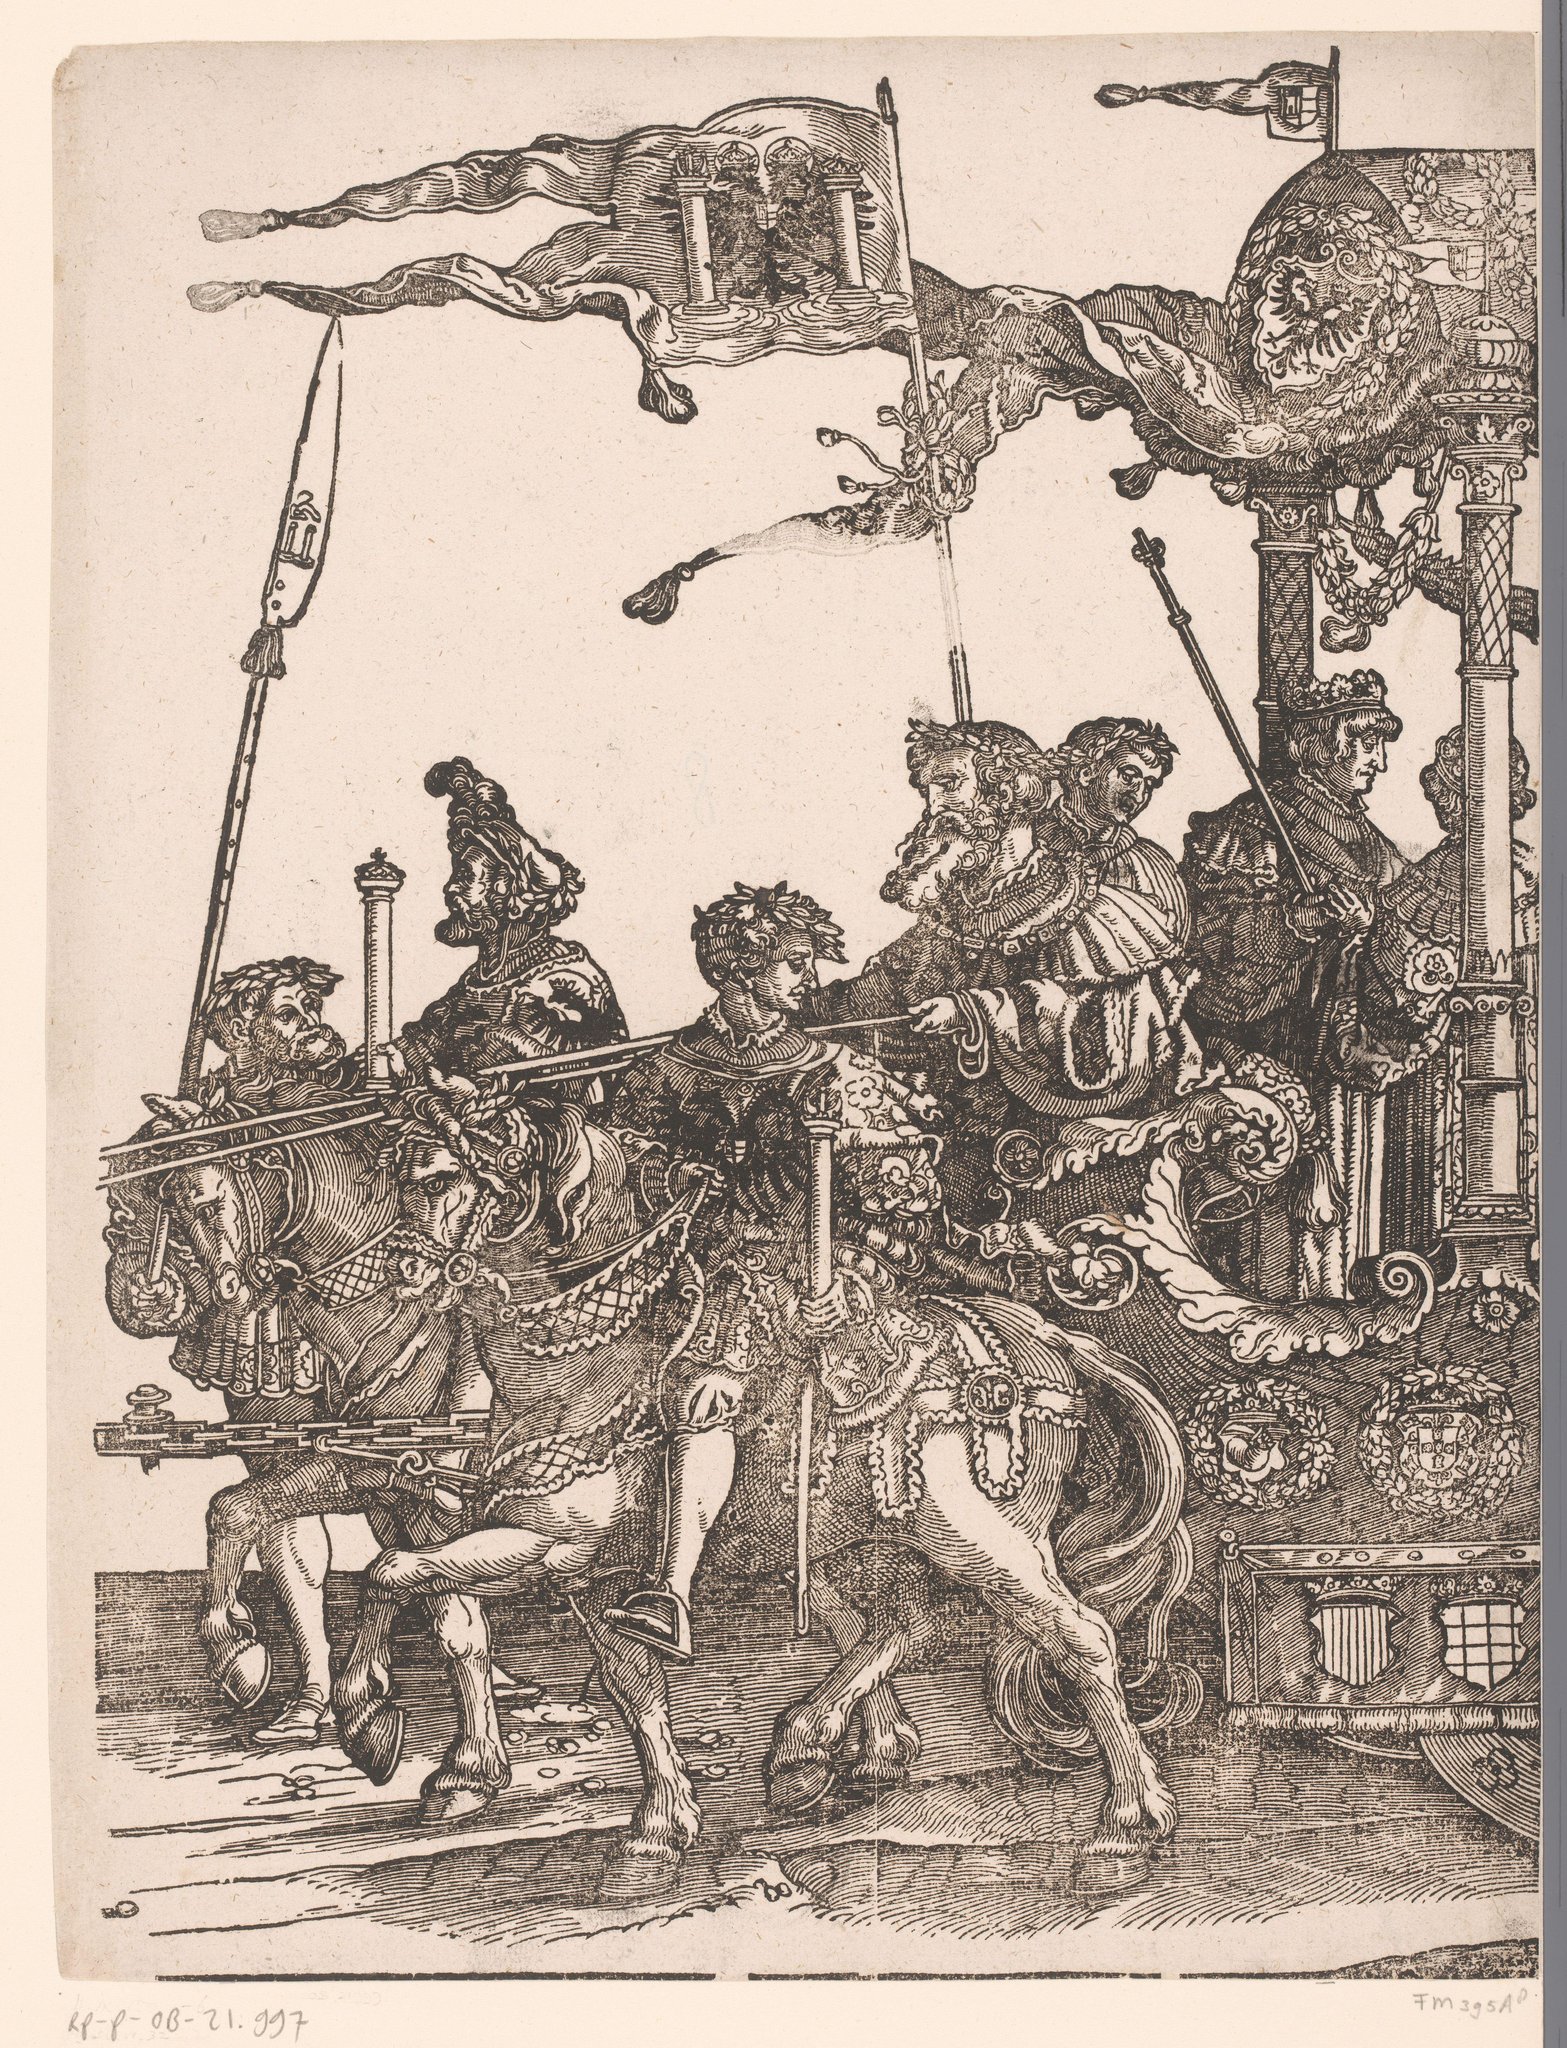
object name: print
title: Voorste deel van de triomfkar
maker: Anonymous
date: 1537-1551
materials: paper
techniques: woodcut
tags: ghent, charles v (holy roman emperor and king of spain), triumphal entry and public reception, pageant, 'entrée solennelle', 'joyeuse entrée'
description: Blad 6 van een serie van 9. Onregelmatig afgesneden.